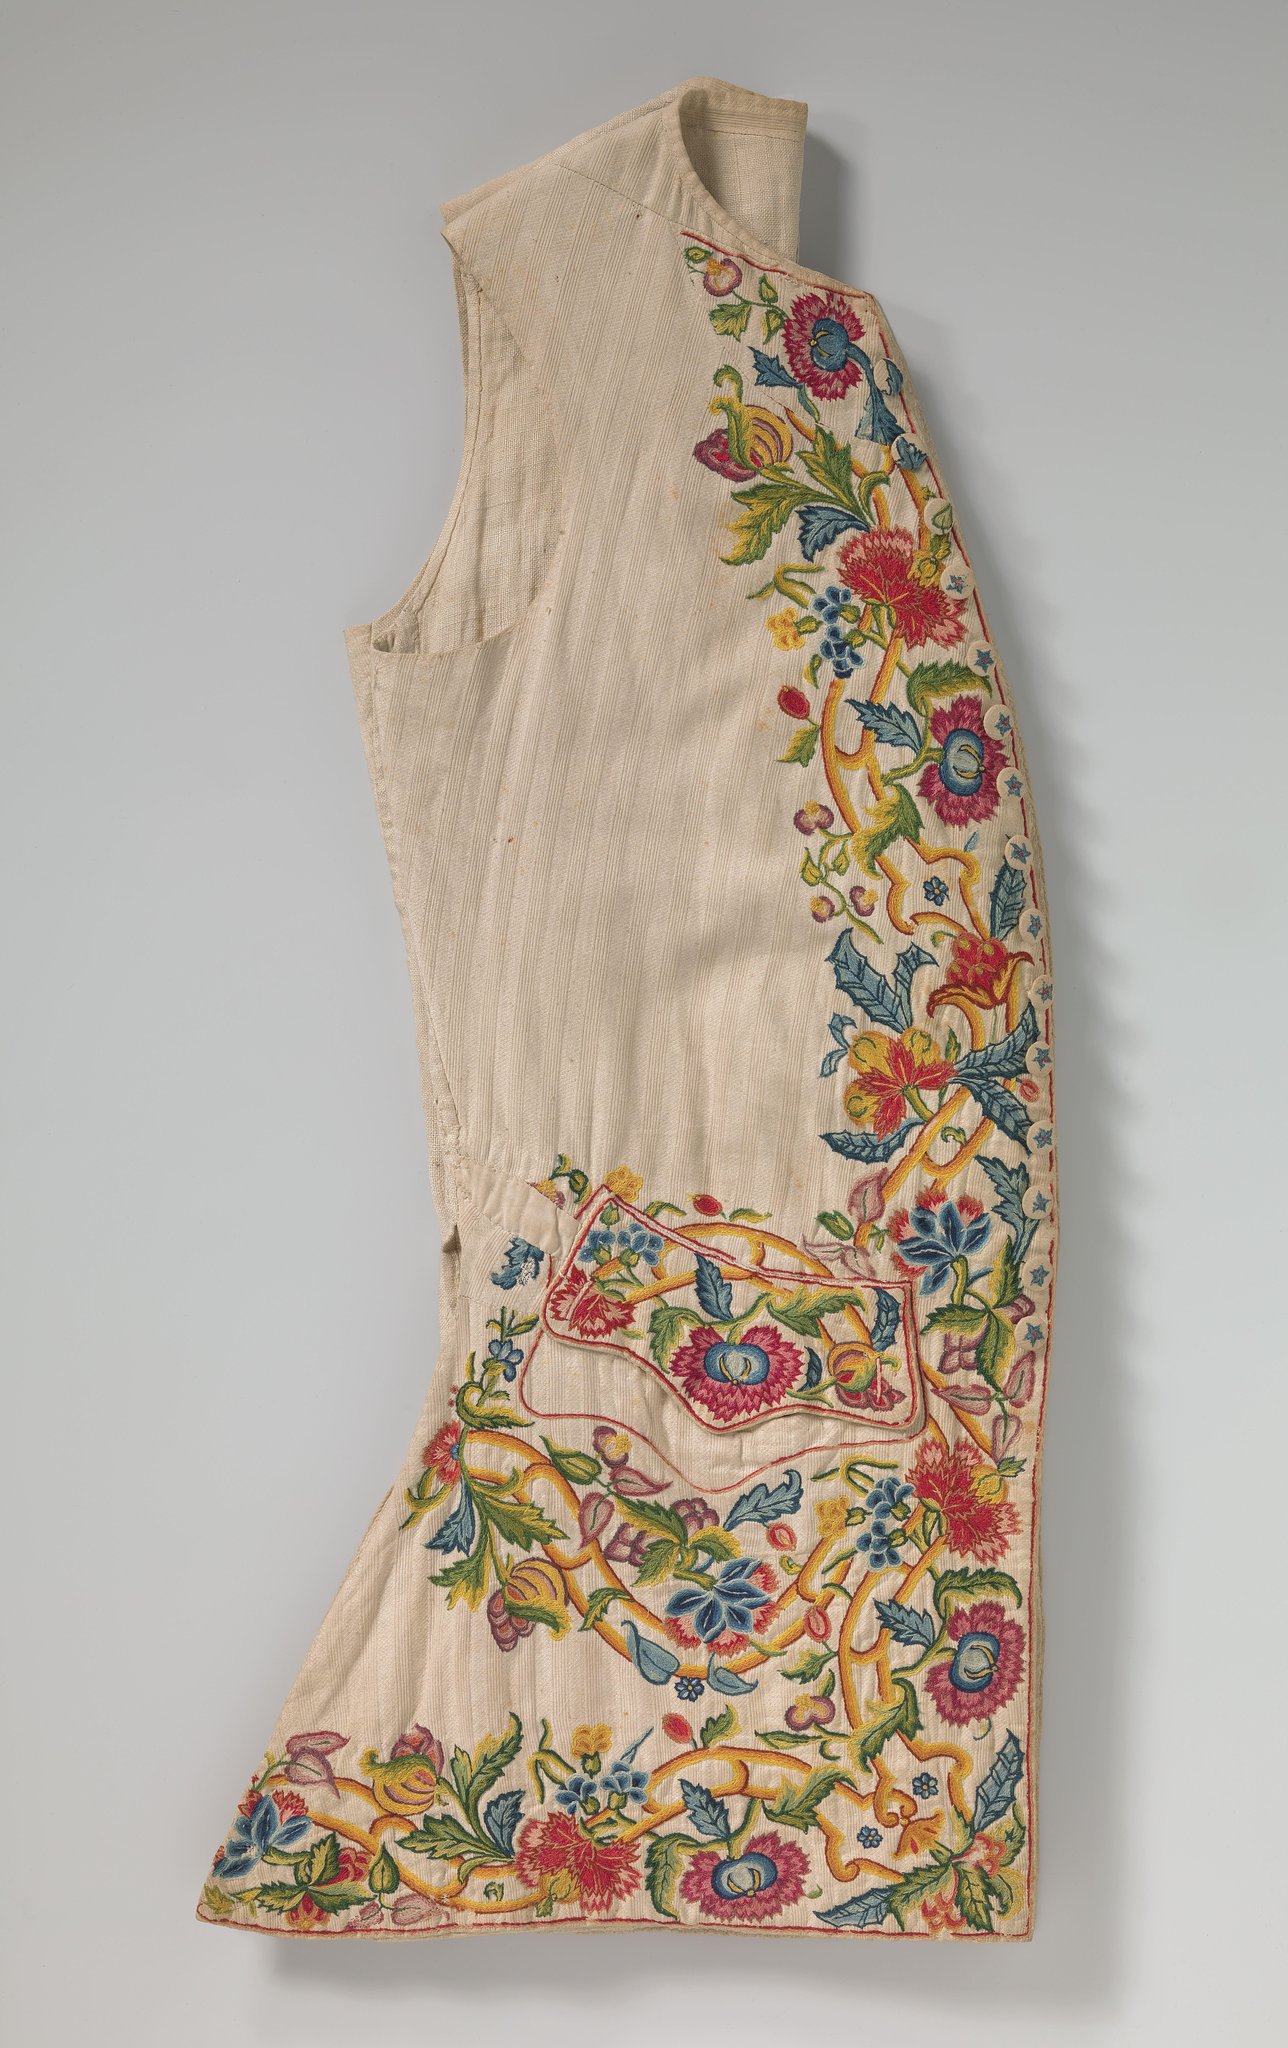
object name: menswear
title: Vest van katoenen piqué, met een geborduurde rand van grote gekleurde bloemen van wol (crewelwork)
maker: Anonymous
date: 1700-1750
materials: cotton, textile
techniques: embroidery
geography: england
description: Vest van katoenen piqué, met een geborduurde rand van grote gekleurde bloemen van wol (crewelwork). Geen kraag, knopen tot aan de hoogte van de zak. Grof linnen gespleten rug met bandsluiting. Voering van linnen. (Onderjas ?)